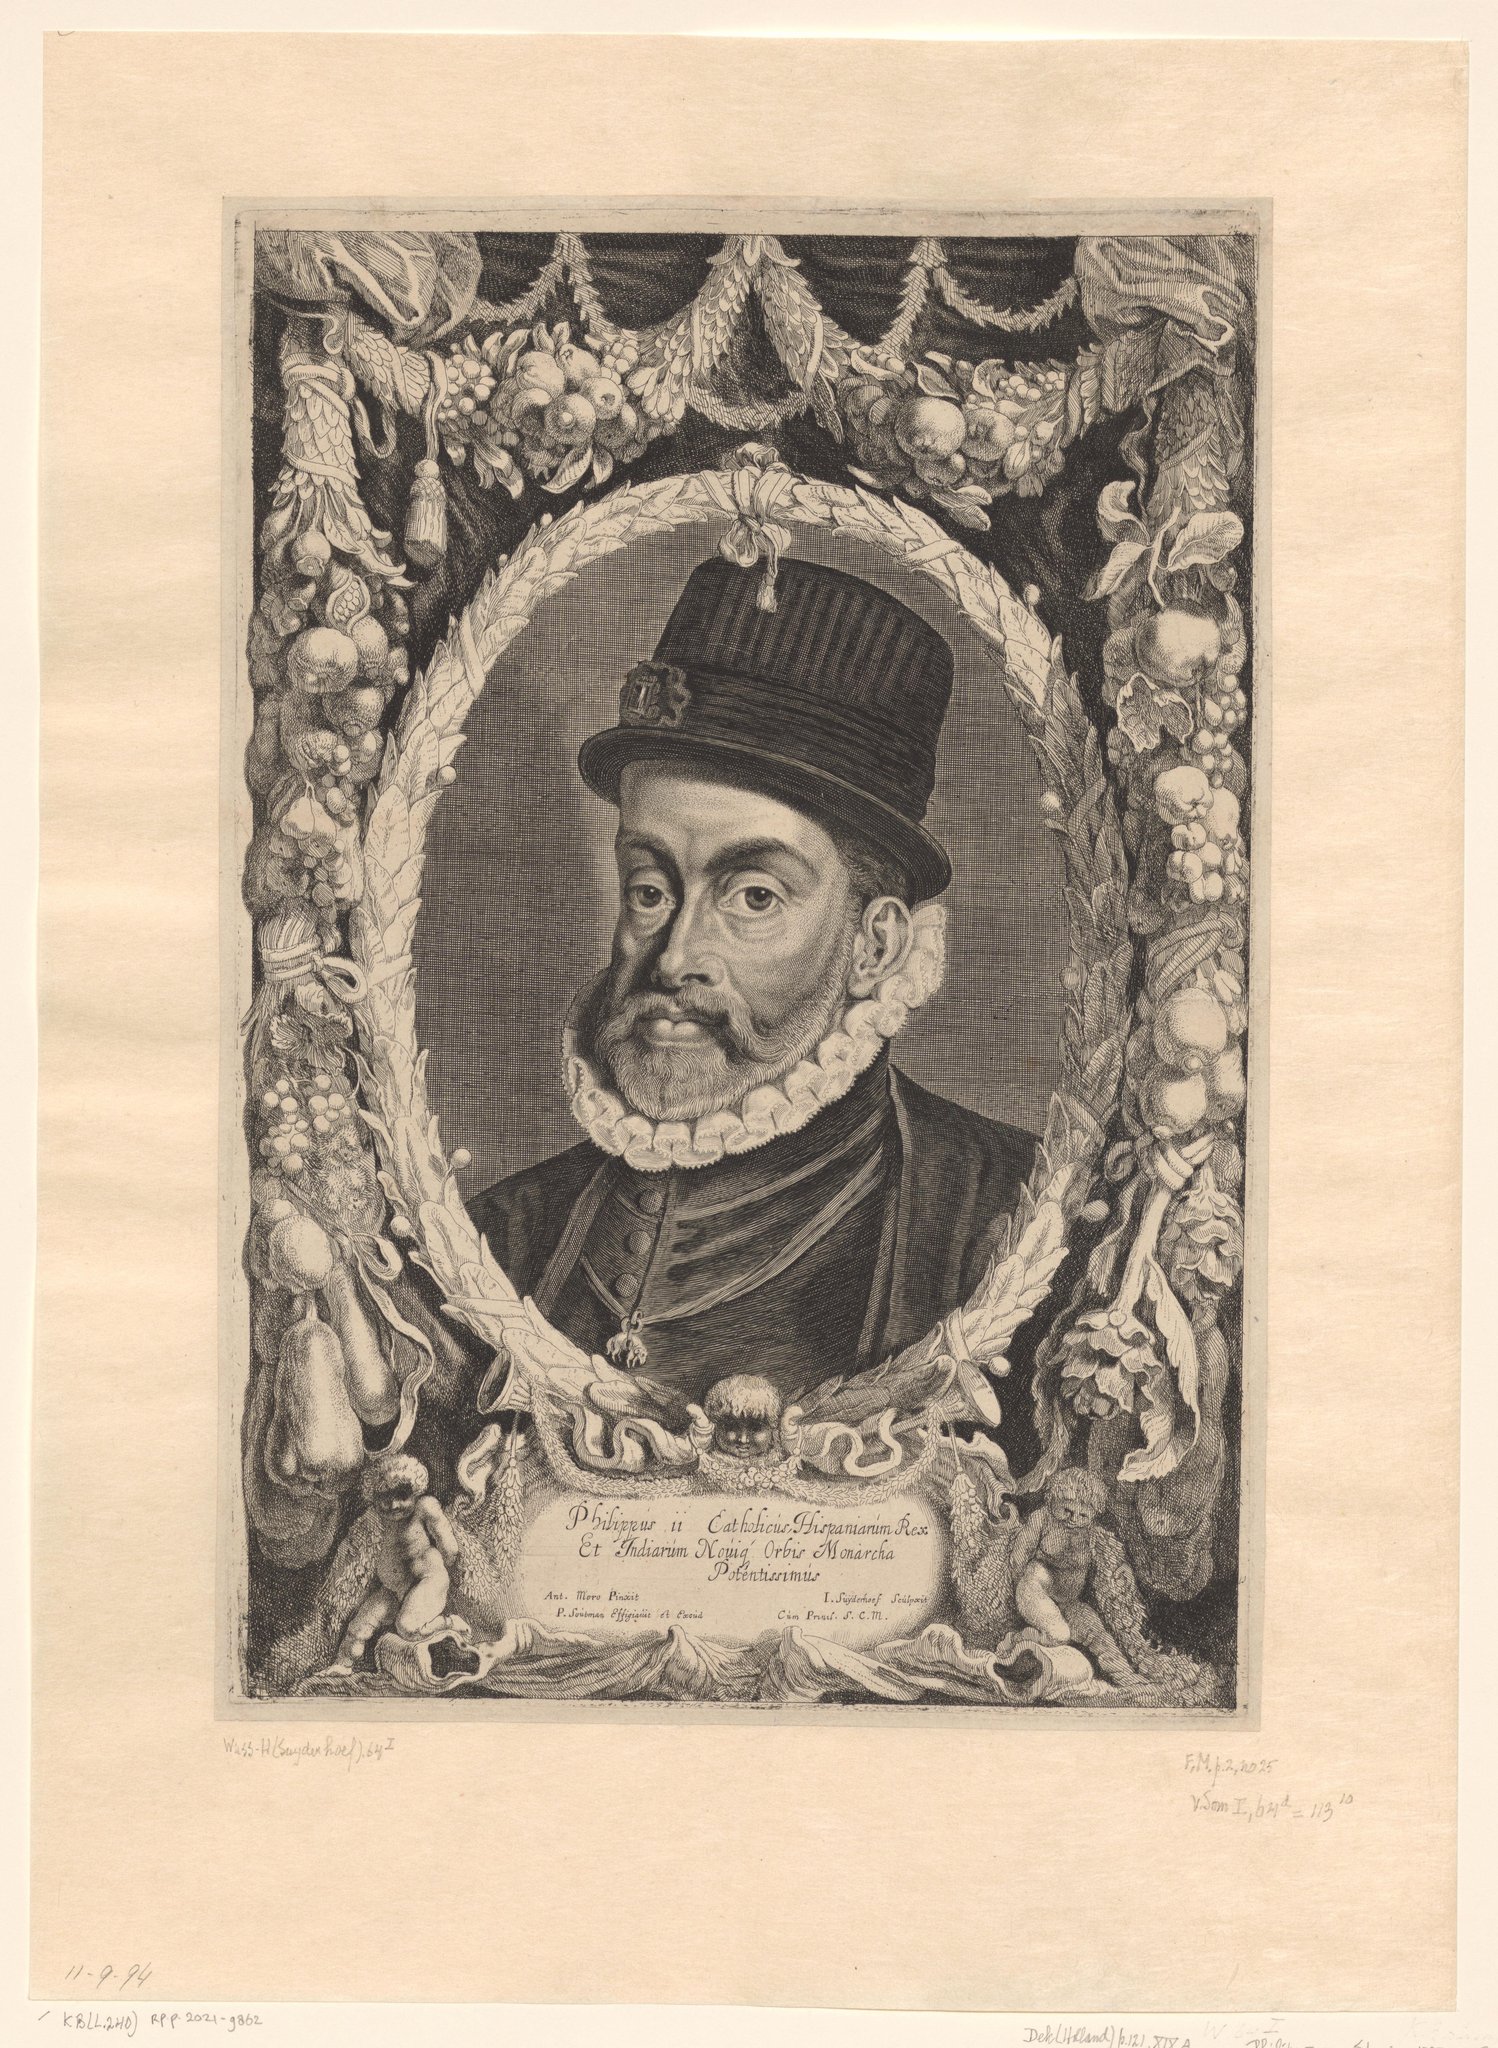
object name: print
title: Duces Burgundiae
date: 1644-1650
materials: paper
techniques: engraving, etching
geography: haarlem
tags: philip ii of spain, adult man, historical persons, knighthood order of the golden fleece, ornament ~ festoon, garland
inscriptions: inscription: ‘WH64I’, collector's mark: Lugt 240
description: Portret van Filips II, koning van Spanje, met een keten met het ordeteken van de Orde van het Gulden Vlies om zijn hals. Het portret is gevat in een ornamentele omlijsting met guirlandes van vruchten. Midden onder een cartouche met zijn naam en titel in het Latijn.